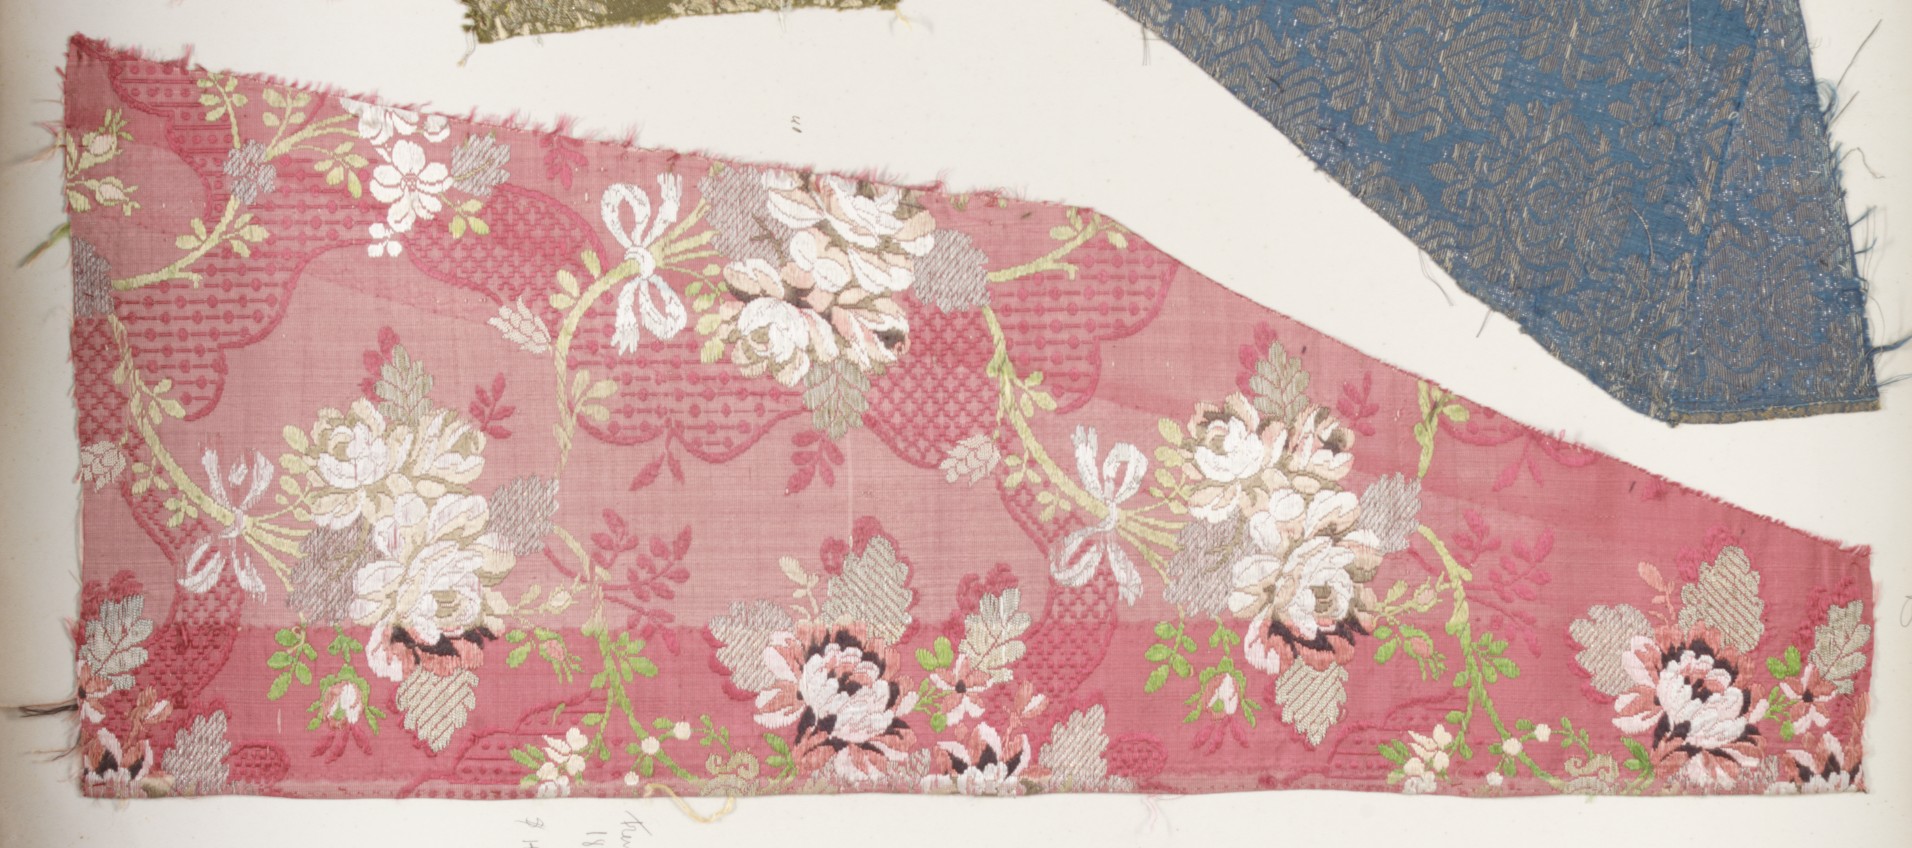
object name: fragment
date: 1701-1800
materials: metal thread, silk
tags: flowers